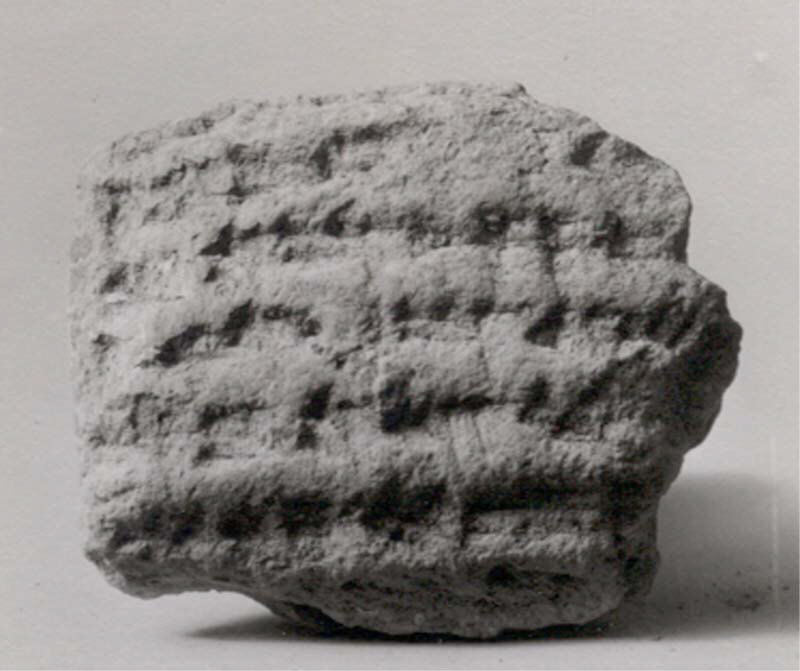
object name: cuneiform tablet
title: Cuneiform tablet: fragment, Ebabbar archive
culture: babylonian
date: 580 BCE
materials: clay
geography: mesopotamia